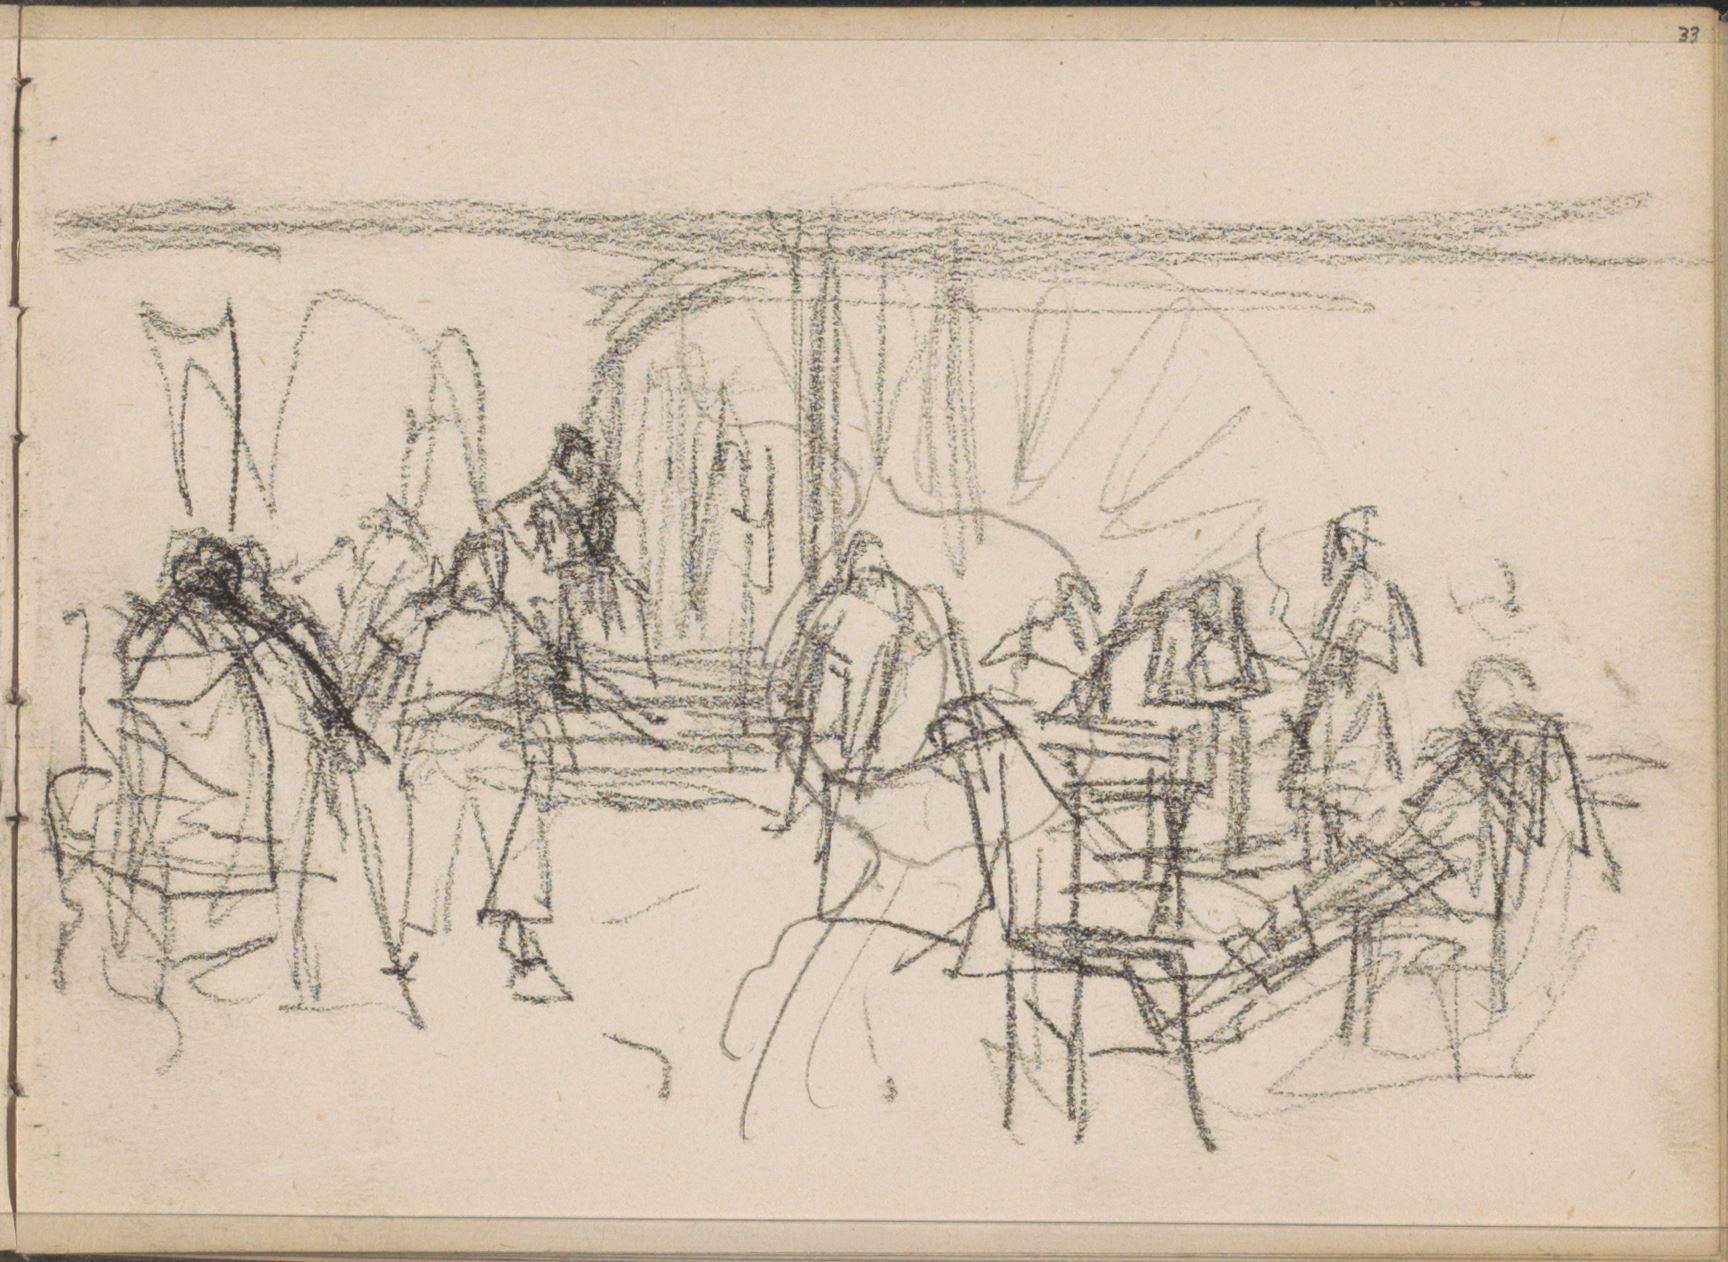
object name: sketchbook leaf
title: Groep figuren, mogelijk in een café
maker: marius bauer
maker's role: draughtsman, print maker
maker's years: 1867-1932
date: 1877-1932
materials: chalk, paper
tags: anatomy (non-medical), inn, coffee-house, public house, etc., chair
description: Pagina 33 uit een schetsboek met 32 bladen.